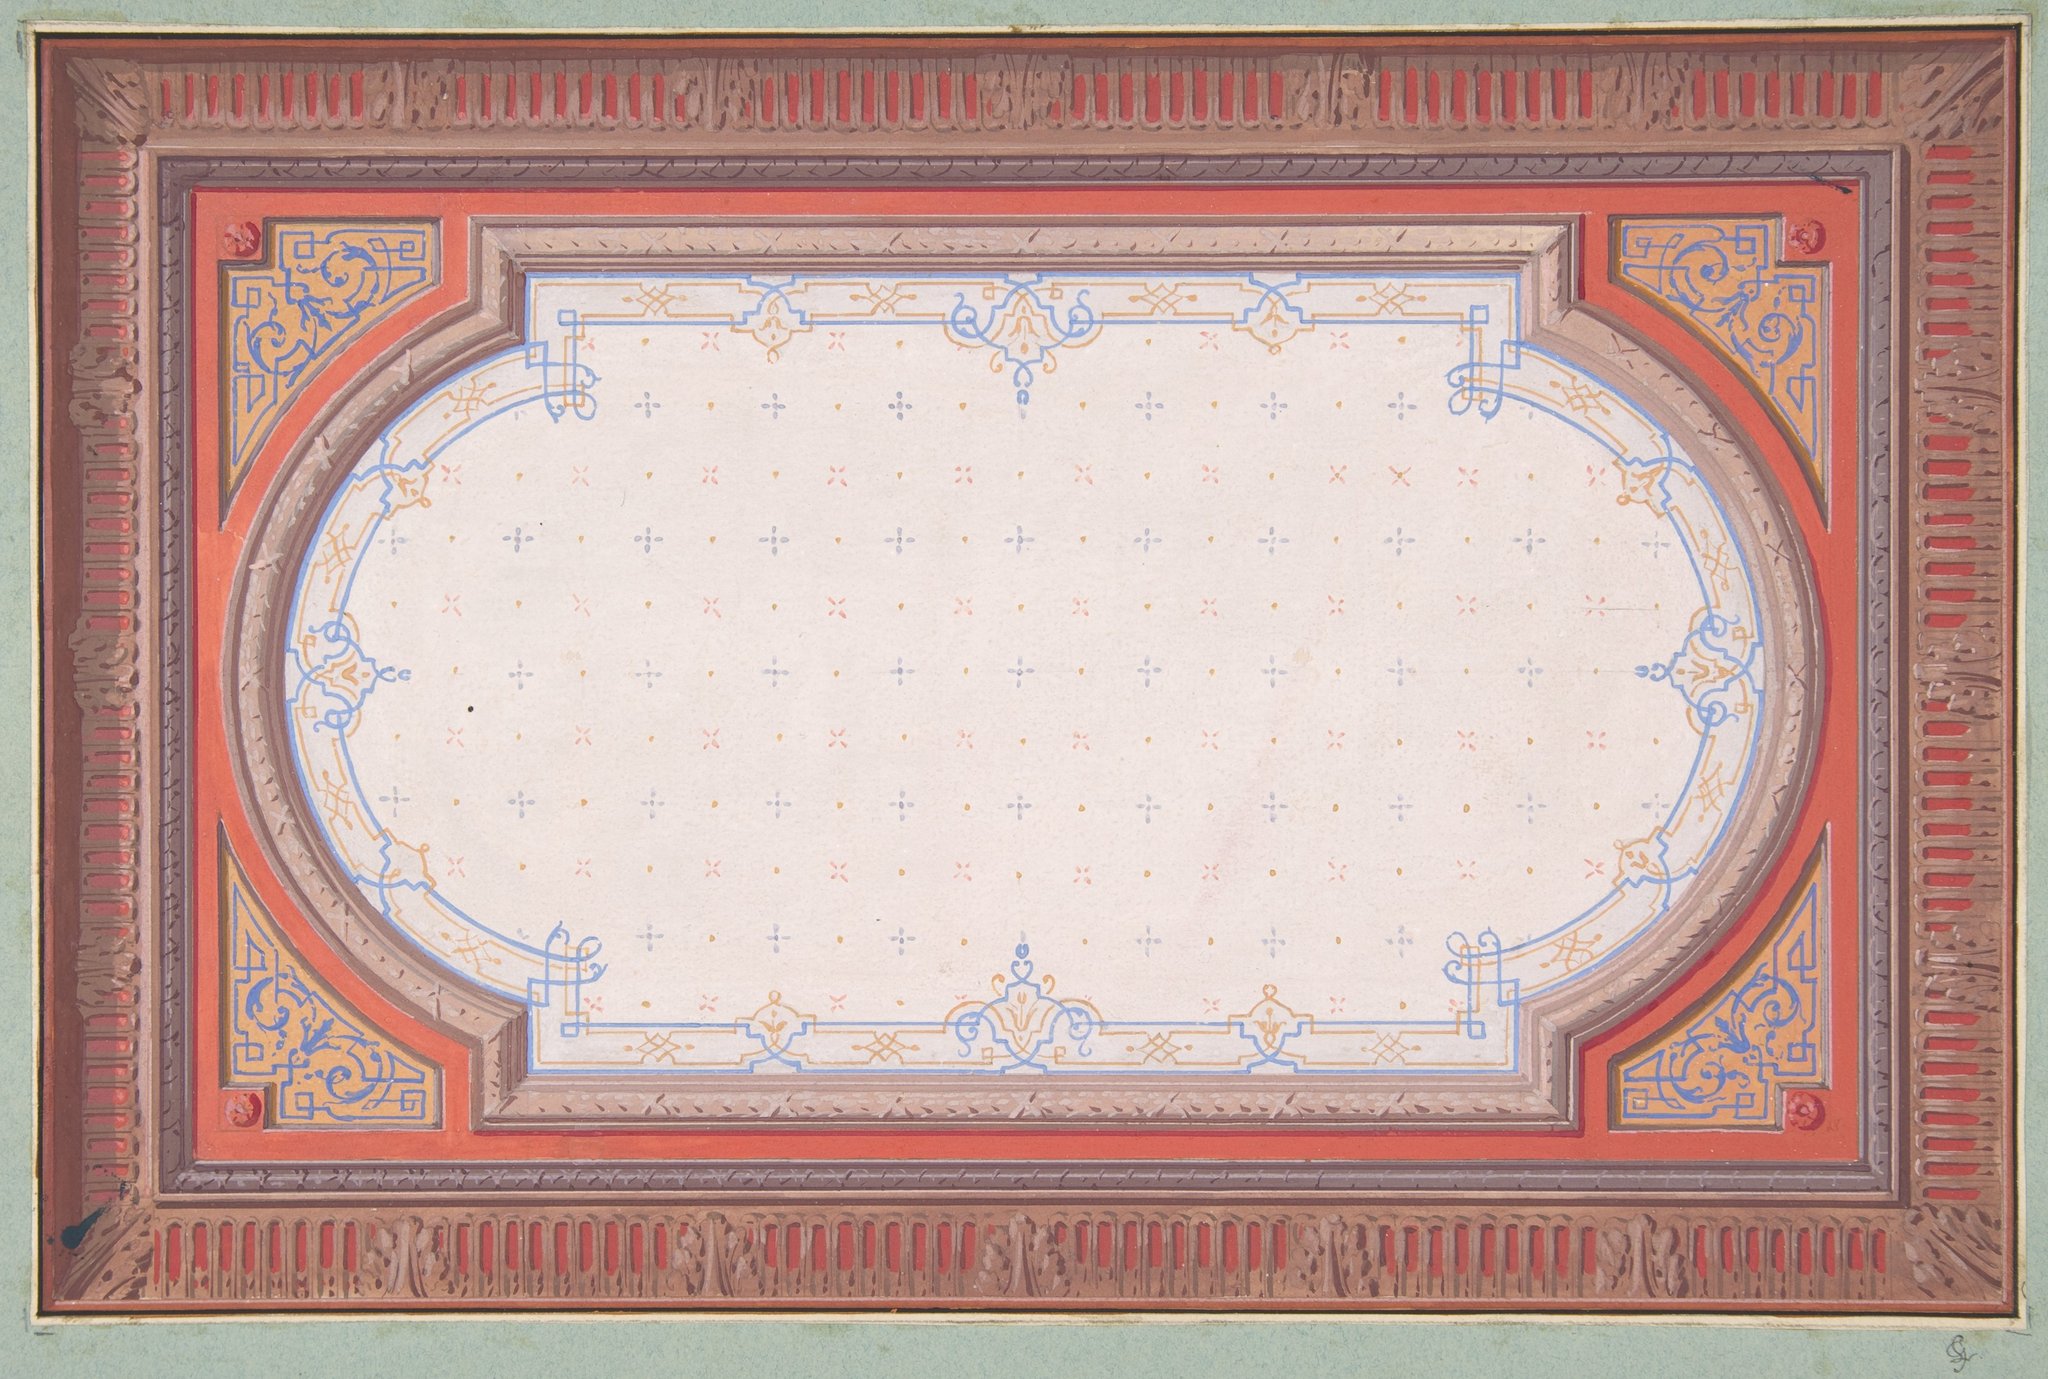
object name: drawing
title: Design for a ceiling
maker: jules-edmond-charles lachaise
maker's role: artist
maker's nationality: french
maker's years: 1897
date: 1851-1900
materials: gouache, graphite, watercolor